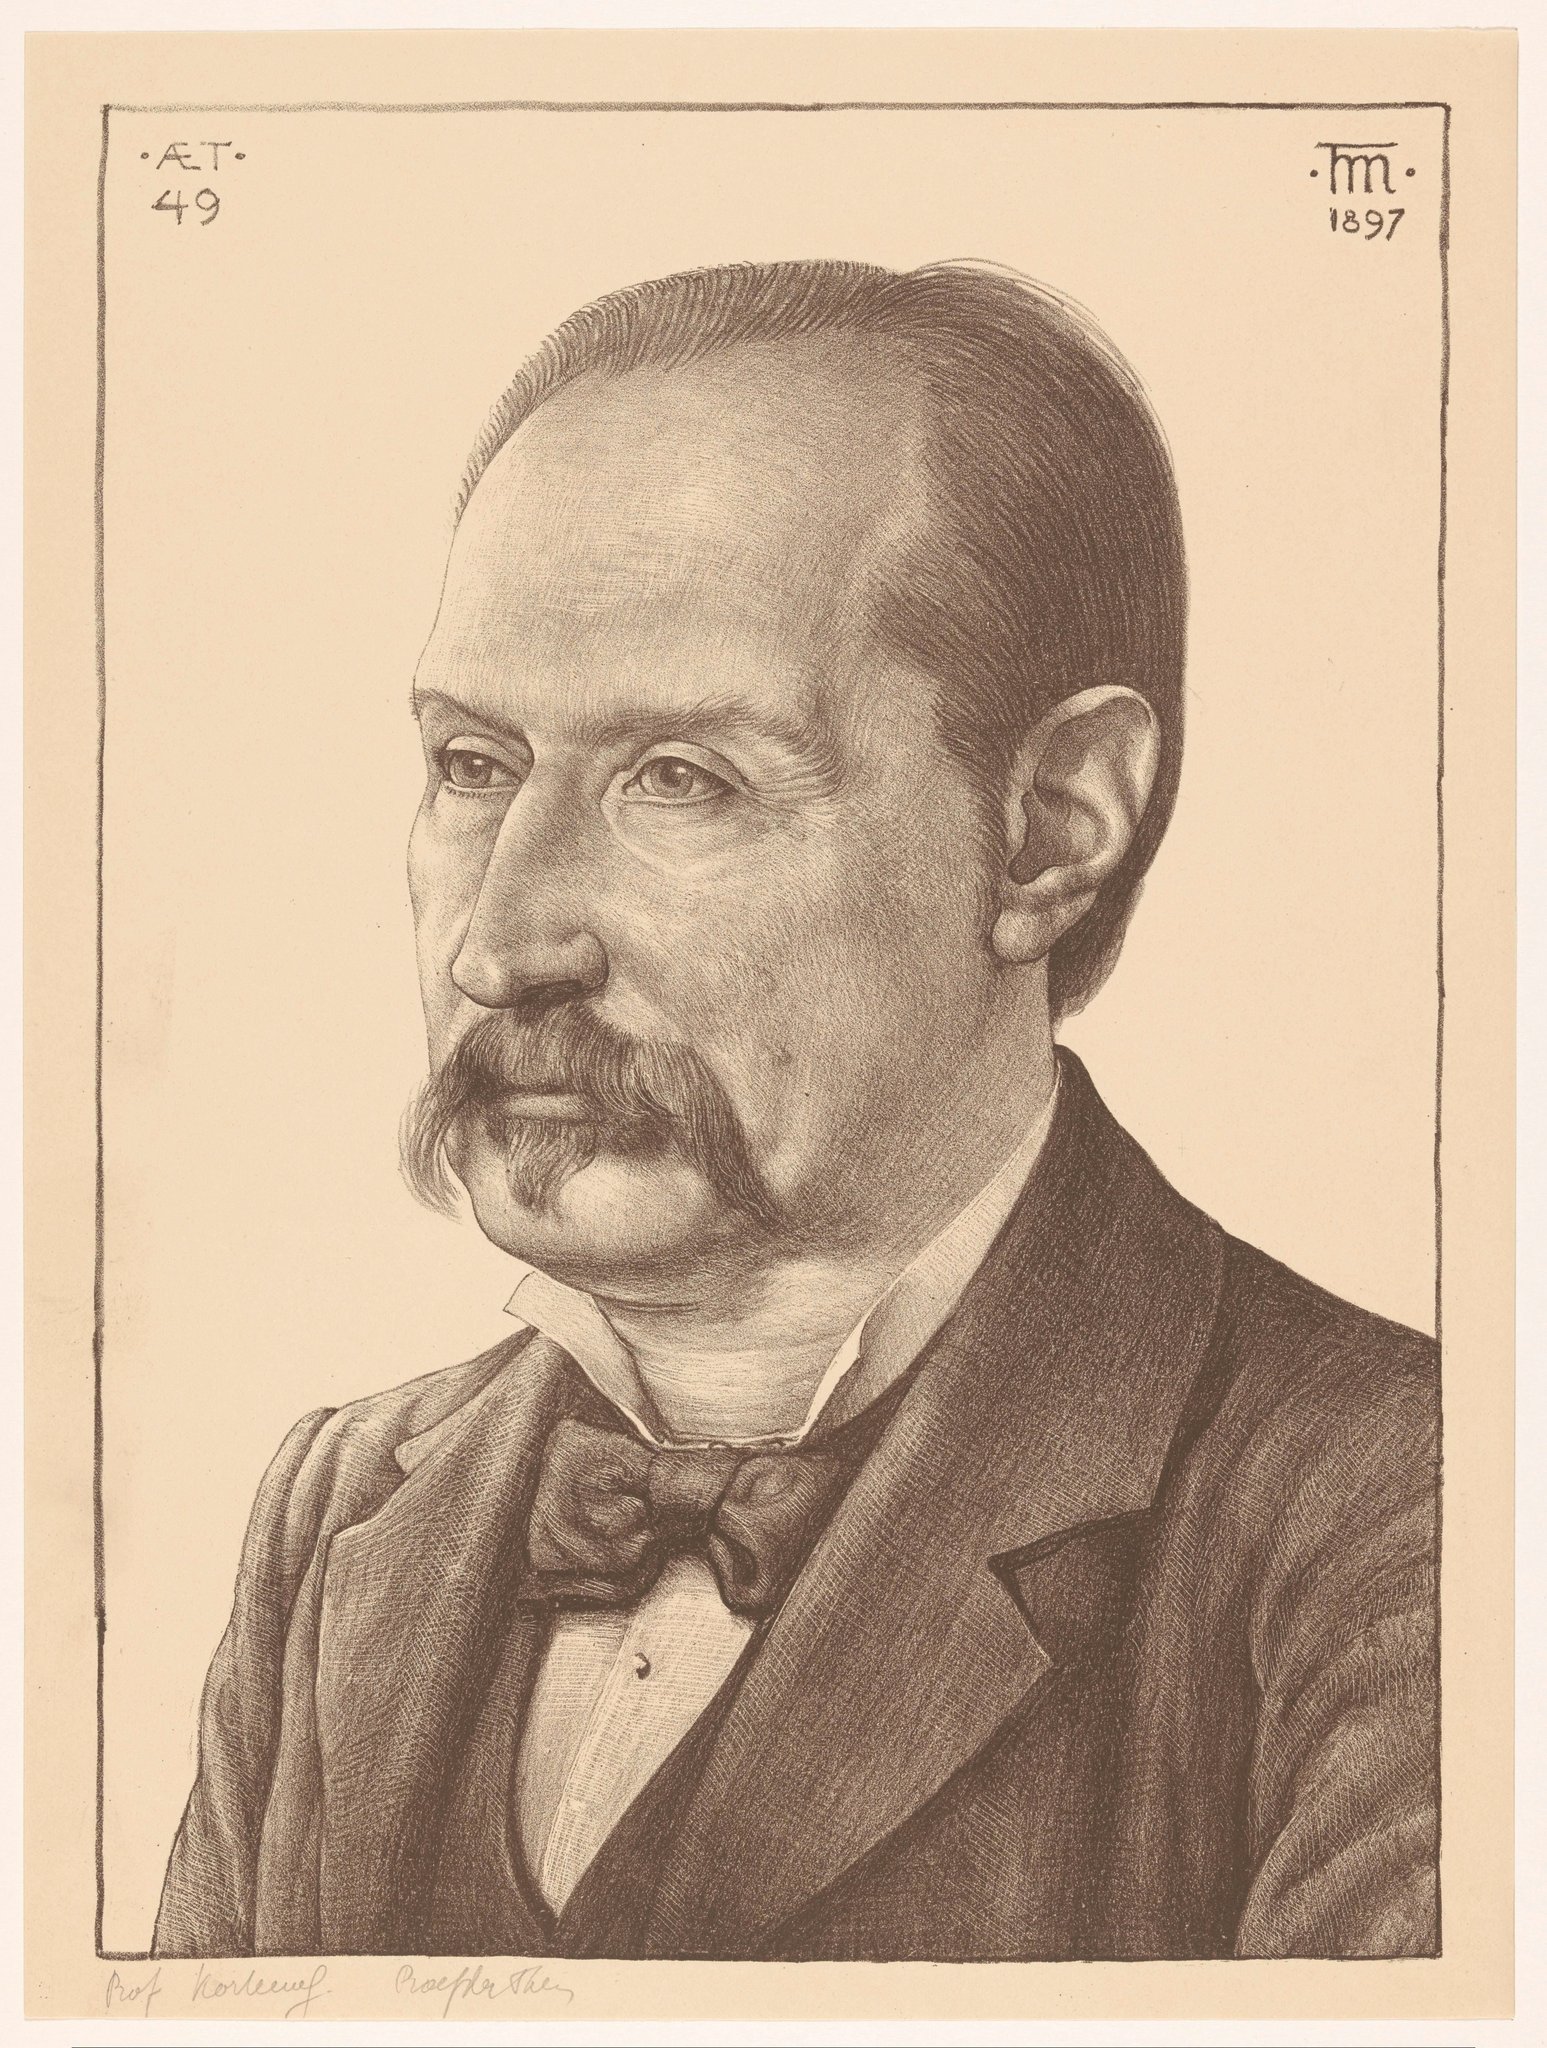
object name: print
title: Portret van Prof. Diederik Johannes Korteweg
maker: theo molkenboer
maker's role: draughtsman, print maker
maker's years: 1871-1920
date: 1897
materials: paper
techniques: lithograph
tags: den bosch, amsterdam, moustache, historical persons, professor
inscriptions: collector's mark: Lugt 2228